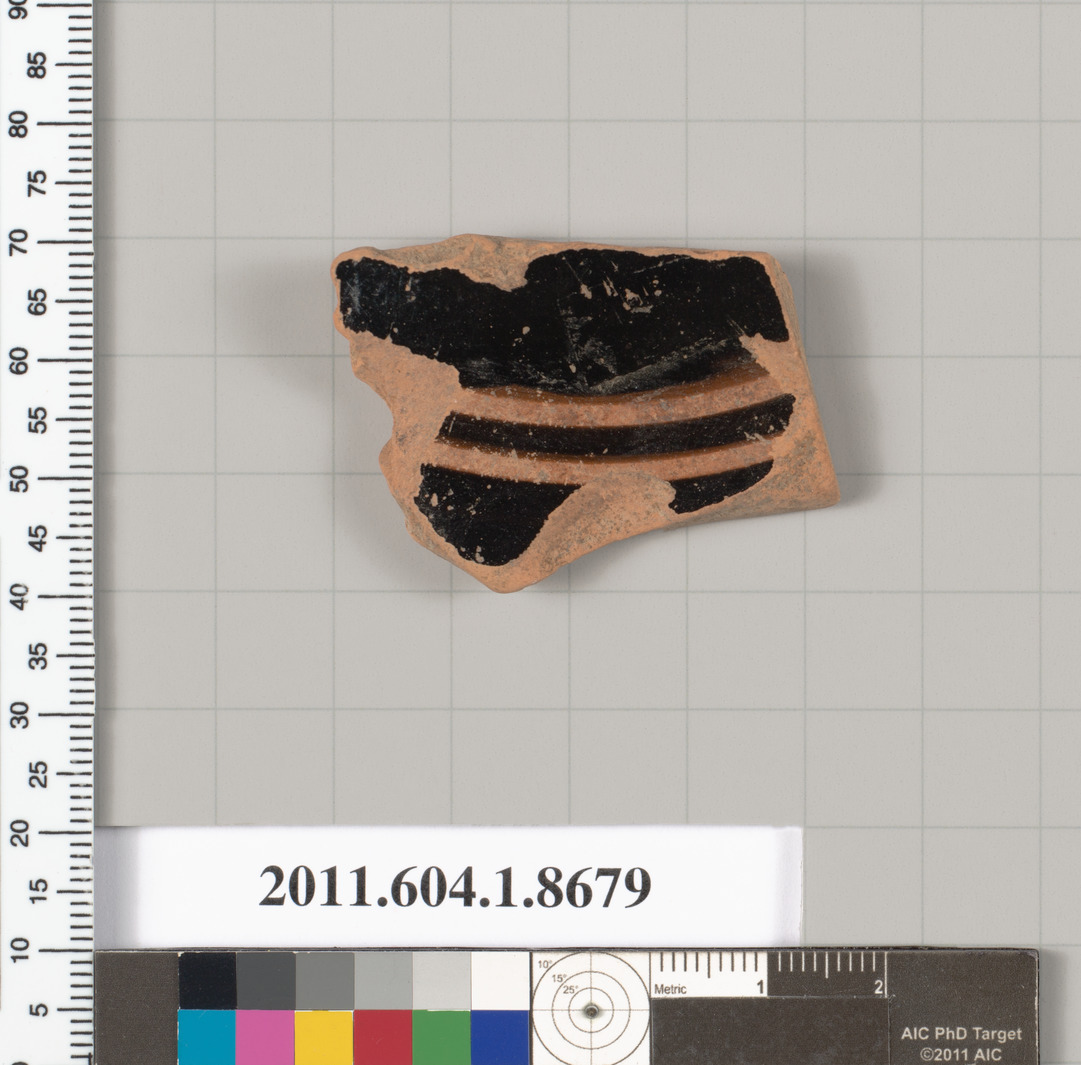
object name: kylix fragment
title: Terracotta fragment of a stemless kylix (drinking cup)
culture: greek, attic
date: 467-435 BCE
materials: terracotta